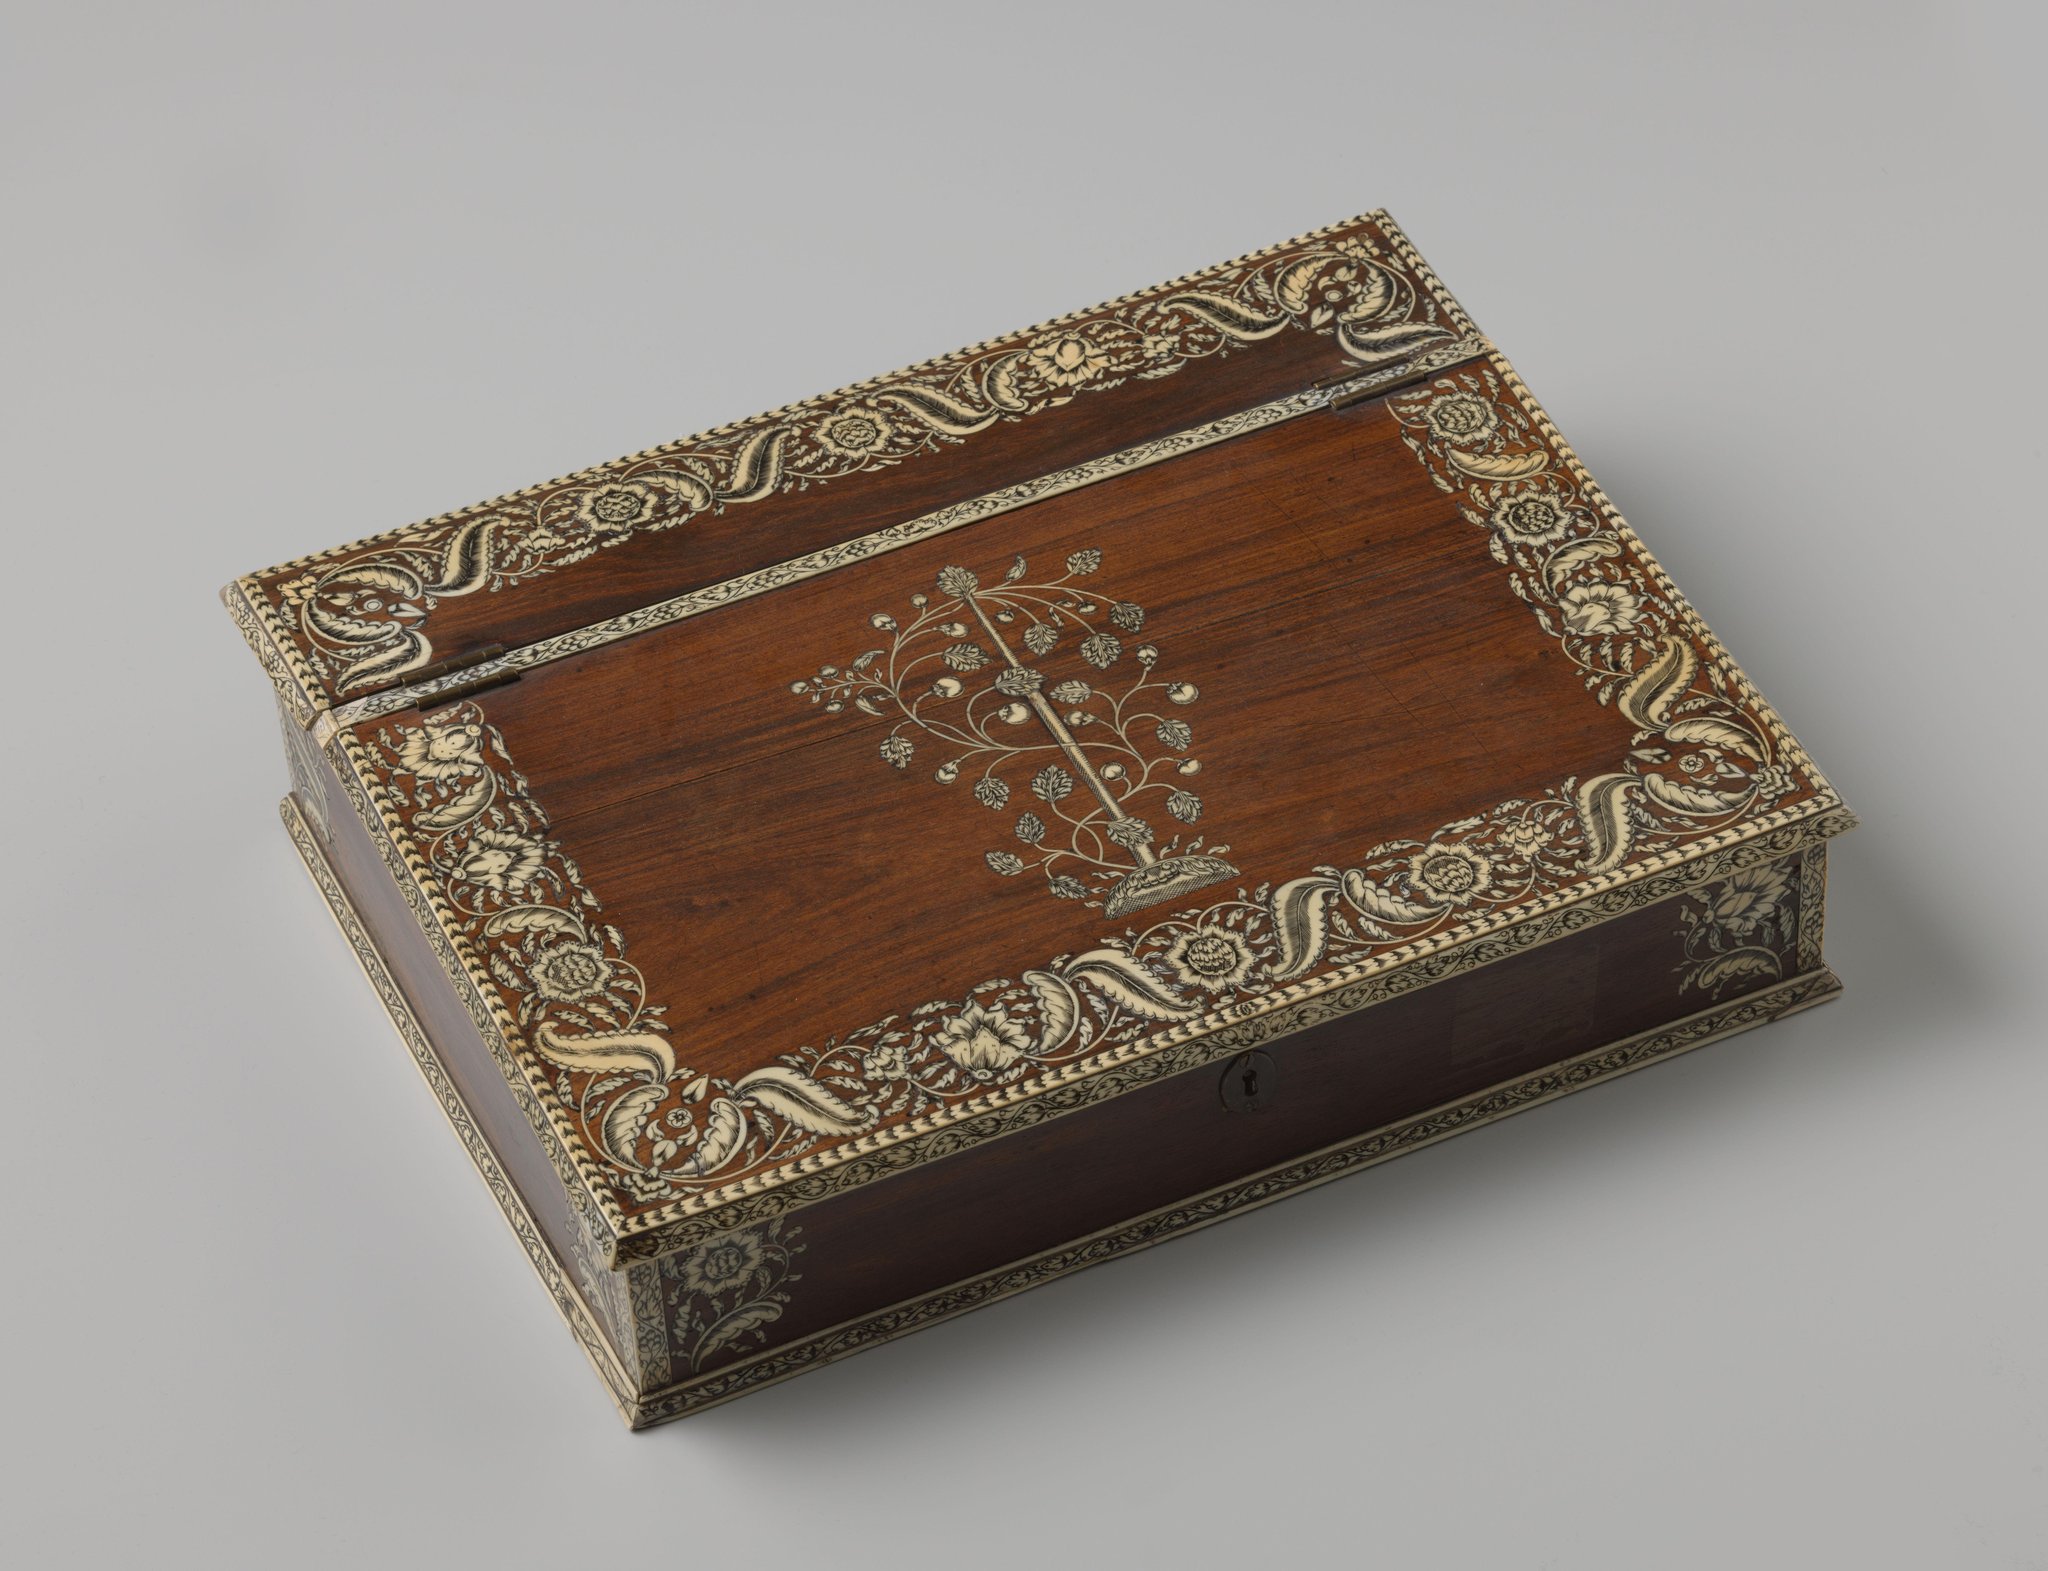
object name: schrijfdoos, schrijfcassette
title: Schrijfcassette van palissanderhout, ingelegd met ivoor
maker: Anonymous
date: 1700-1799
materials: copper, ivory, wood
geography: india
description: Writing case. Rosewood inlaid with ivory. India, 18th century. Purchased from Stichting Cultuurgeschiedenis Nederlanders Overzee.